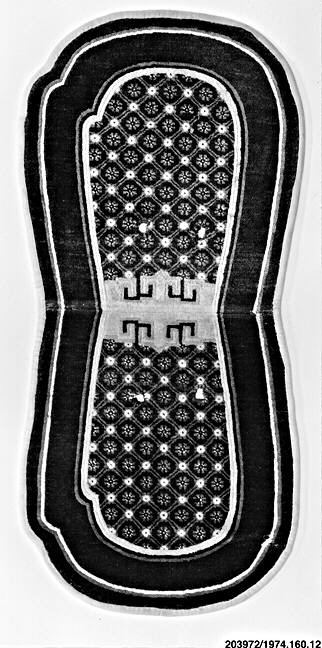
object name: rug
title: Saddle Rug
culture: chinese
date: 1801-1900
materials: cotton, wool